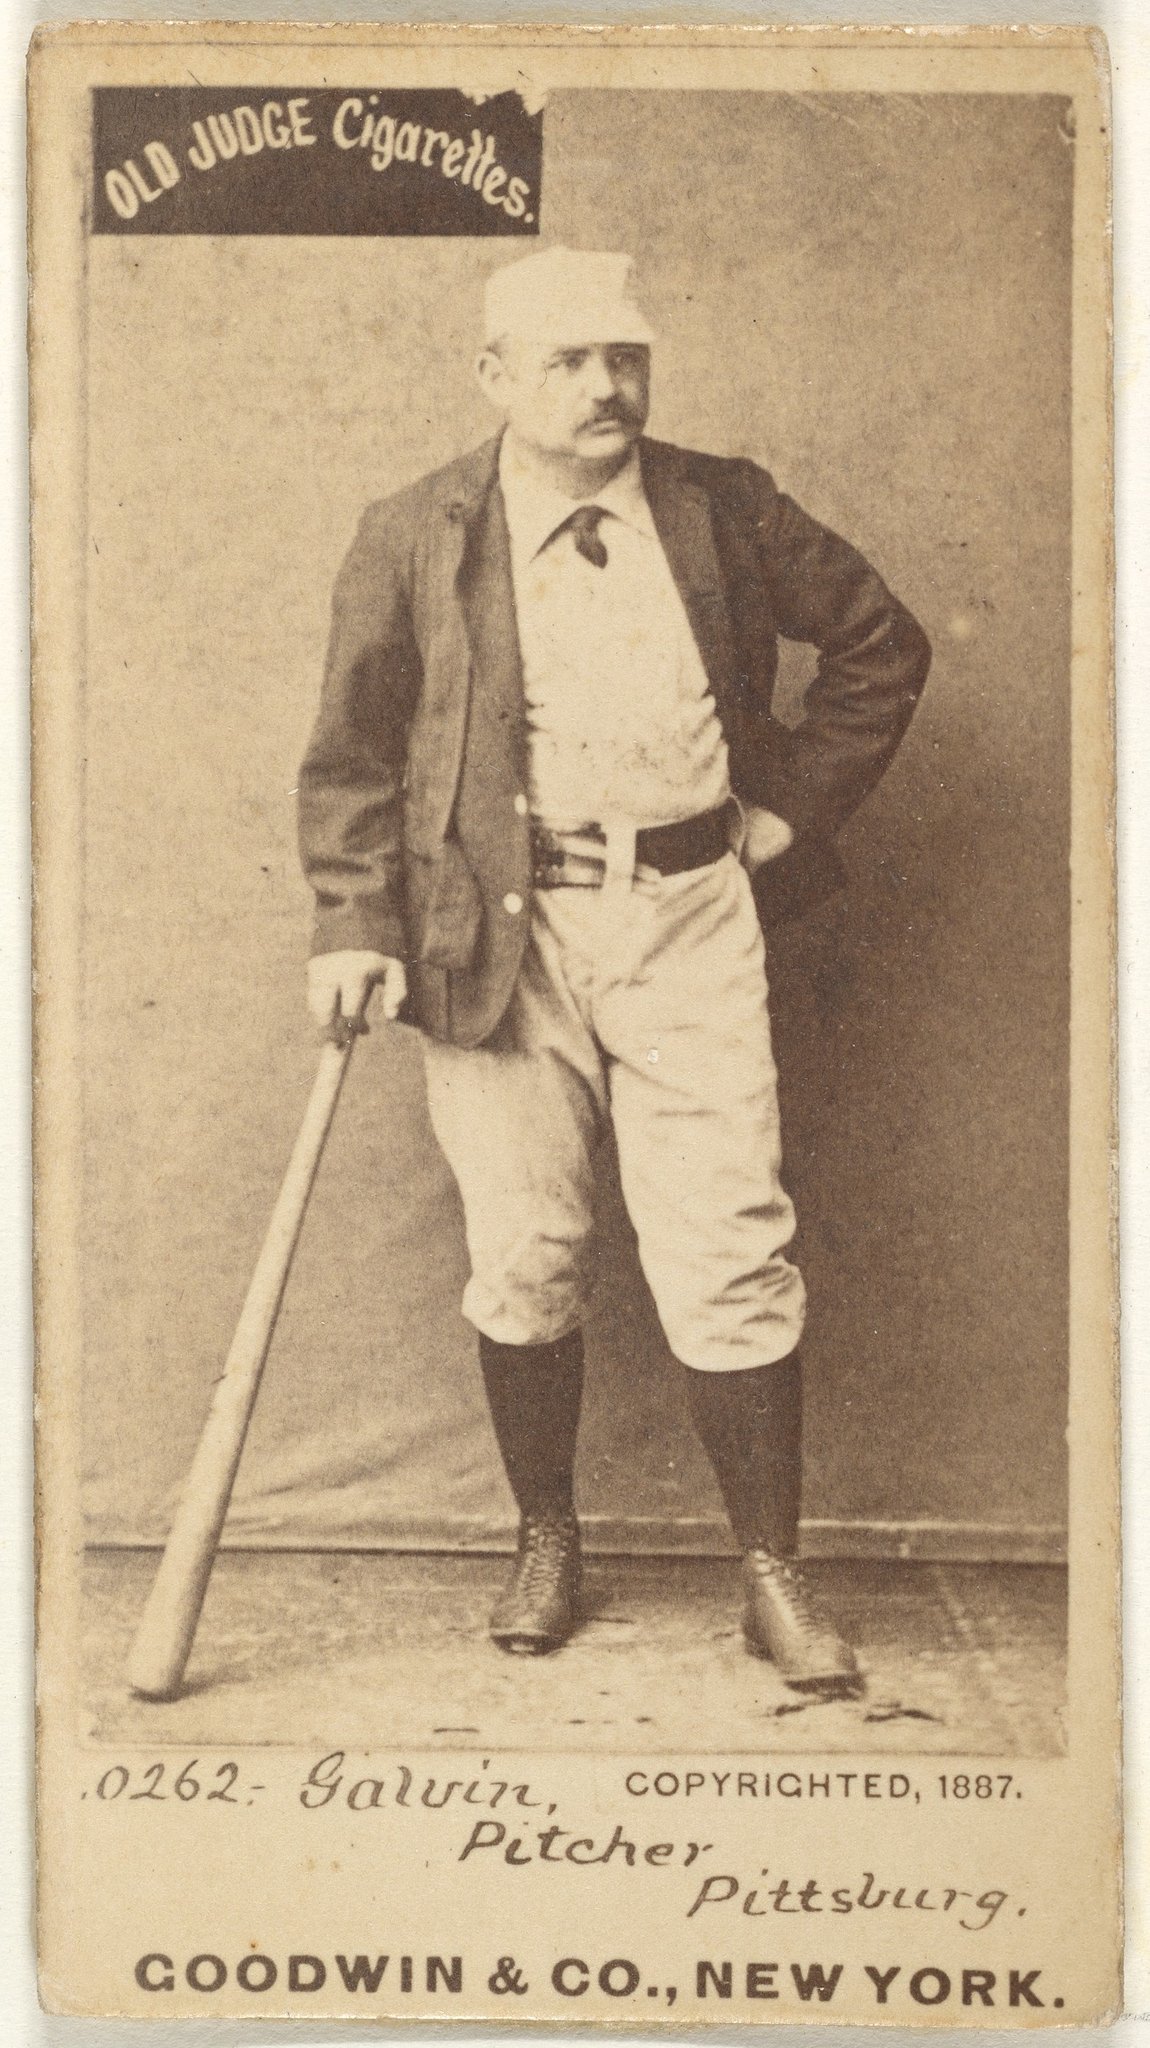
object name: baseball card, photograph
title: James Francis "Pud" Galvin, Pitcher, Pittsburgh, from the Old Judge series (N172) for Old Judge Cigarettes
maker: goodwin & company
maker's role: publisher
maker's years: 1850-1950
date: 1887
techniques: albumen silver print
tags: men,portraits,baseball,athletes